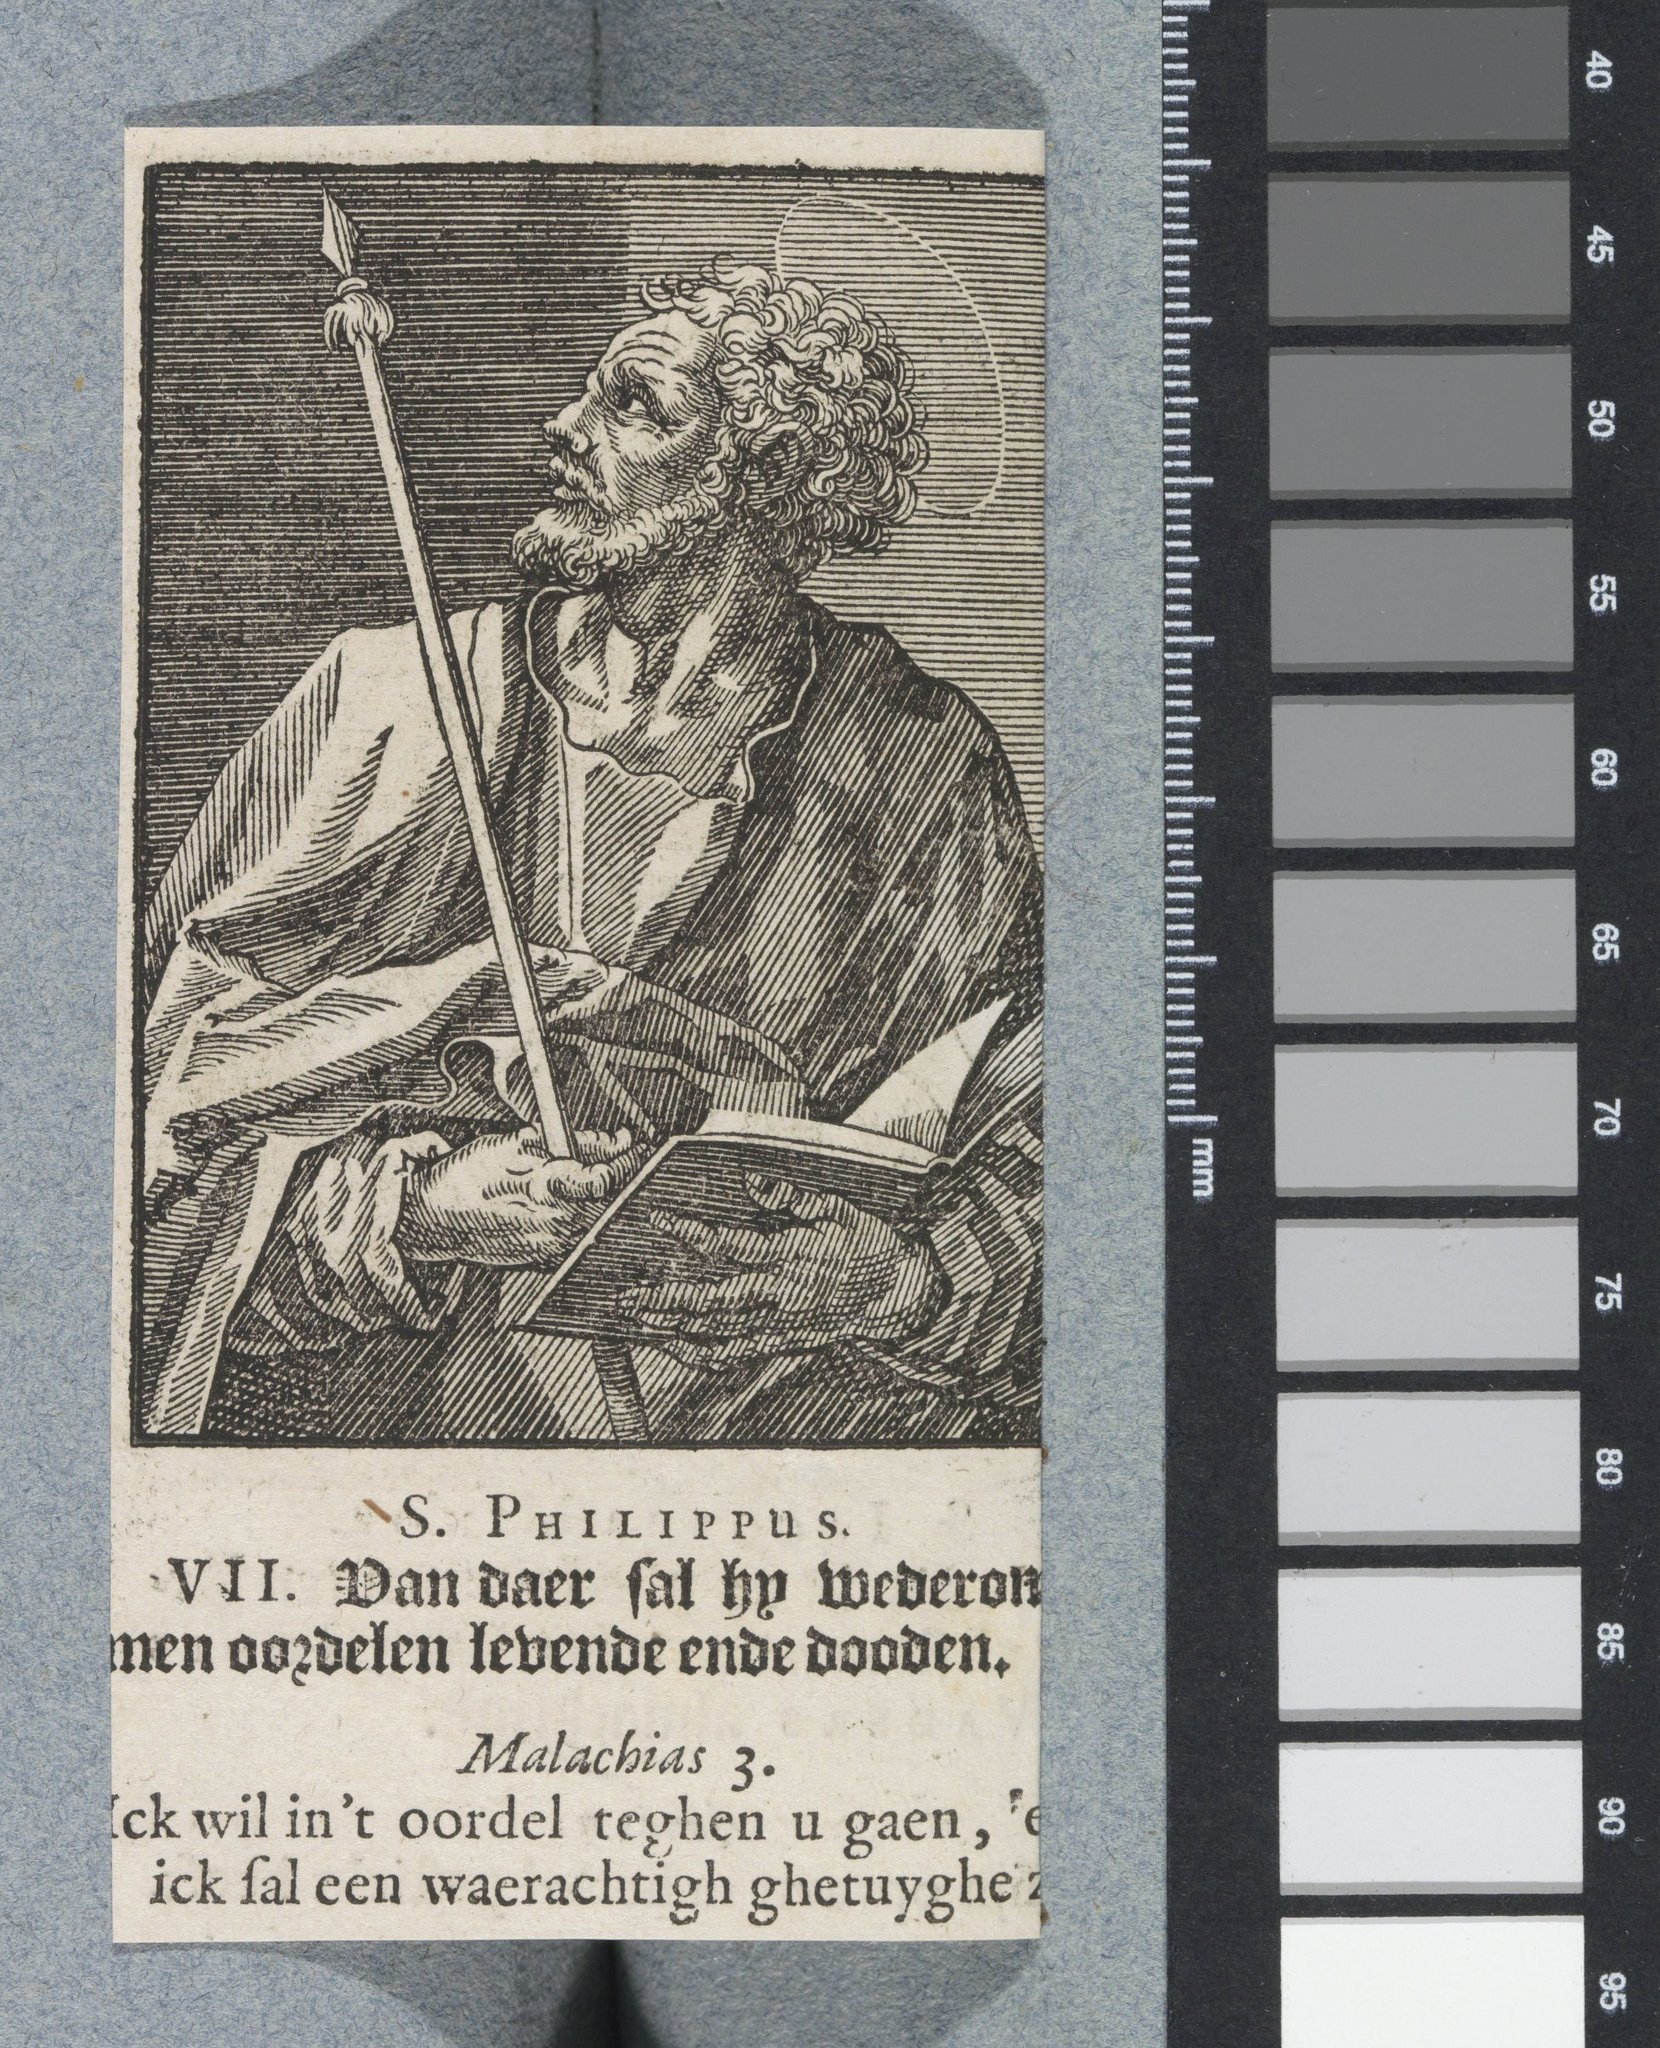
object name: album leaf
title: S. Philippus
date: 1629-1646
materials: paper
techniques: letterpress printing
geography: amsterdam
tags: the apostle philip; possible attributes: book, cross, dish with snake, lance, scroll, stone, sword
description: De prent is afkomstig uit een van de uitgaven van P.J. Paets uit Amsterdam. De prent wordt mogelijkj al gebruikt in: Der Zielen Lust-hof. Leuven, I.Jacbosz voor P.J. Paets [= Amsterdam, P.J. Paets], 1629. Ze komt in ieder geval voor in: Het Nieuwe Testament ons Salichmaeckers Jesu Christi. Amsterdam, P.J. Paets, 1646. De voorstelling is gekopieerd naar een prent van Raphaël I Sadeler naar Maerten de Vos, aldaar gepresenteerd als Apostel Tomas.